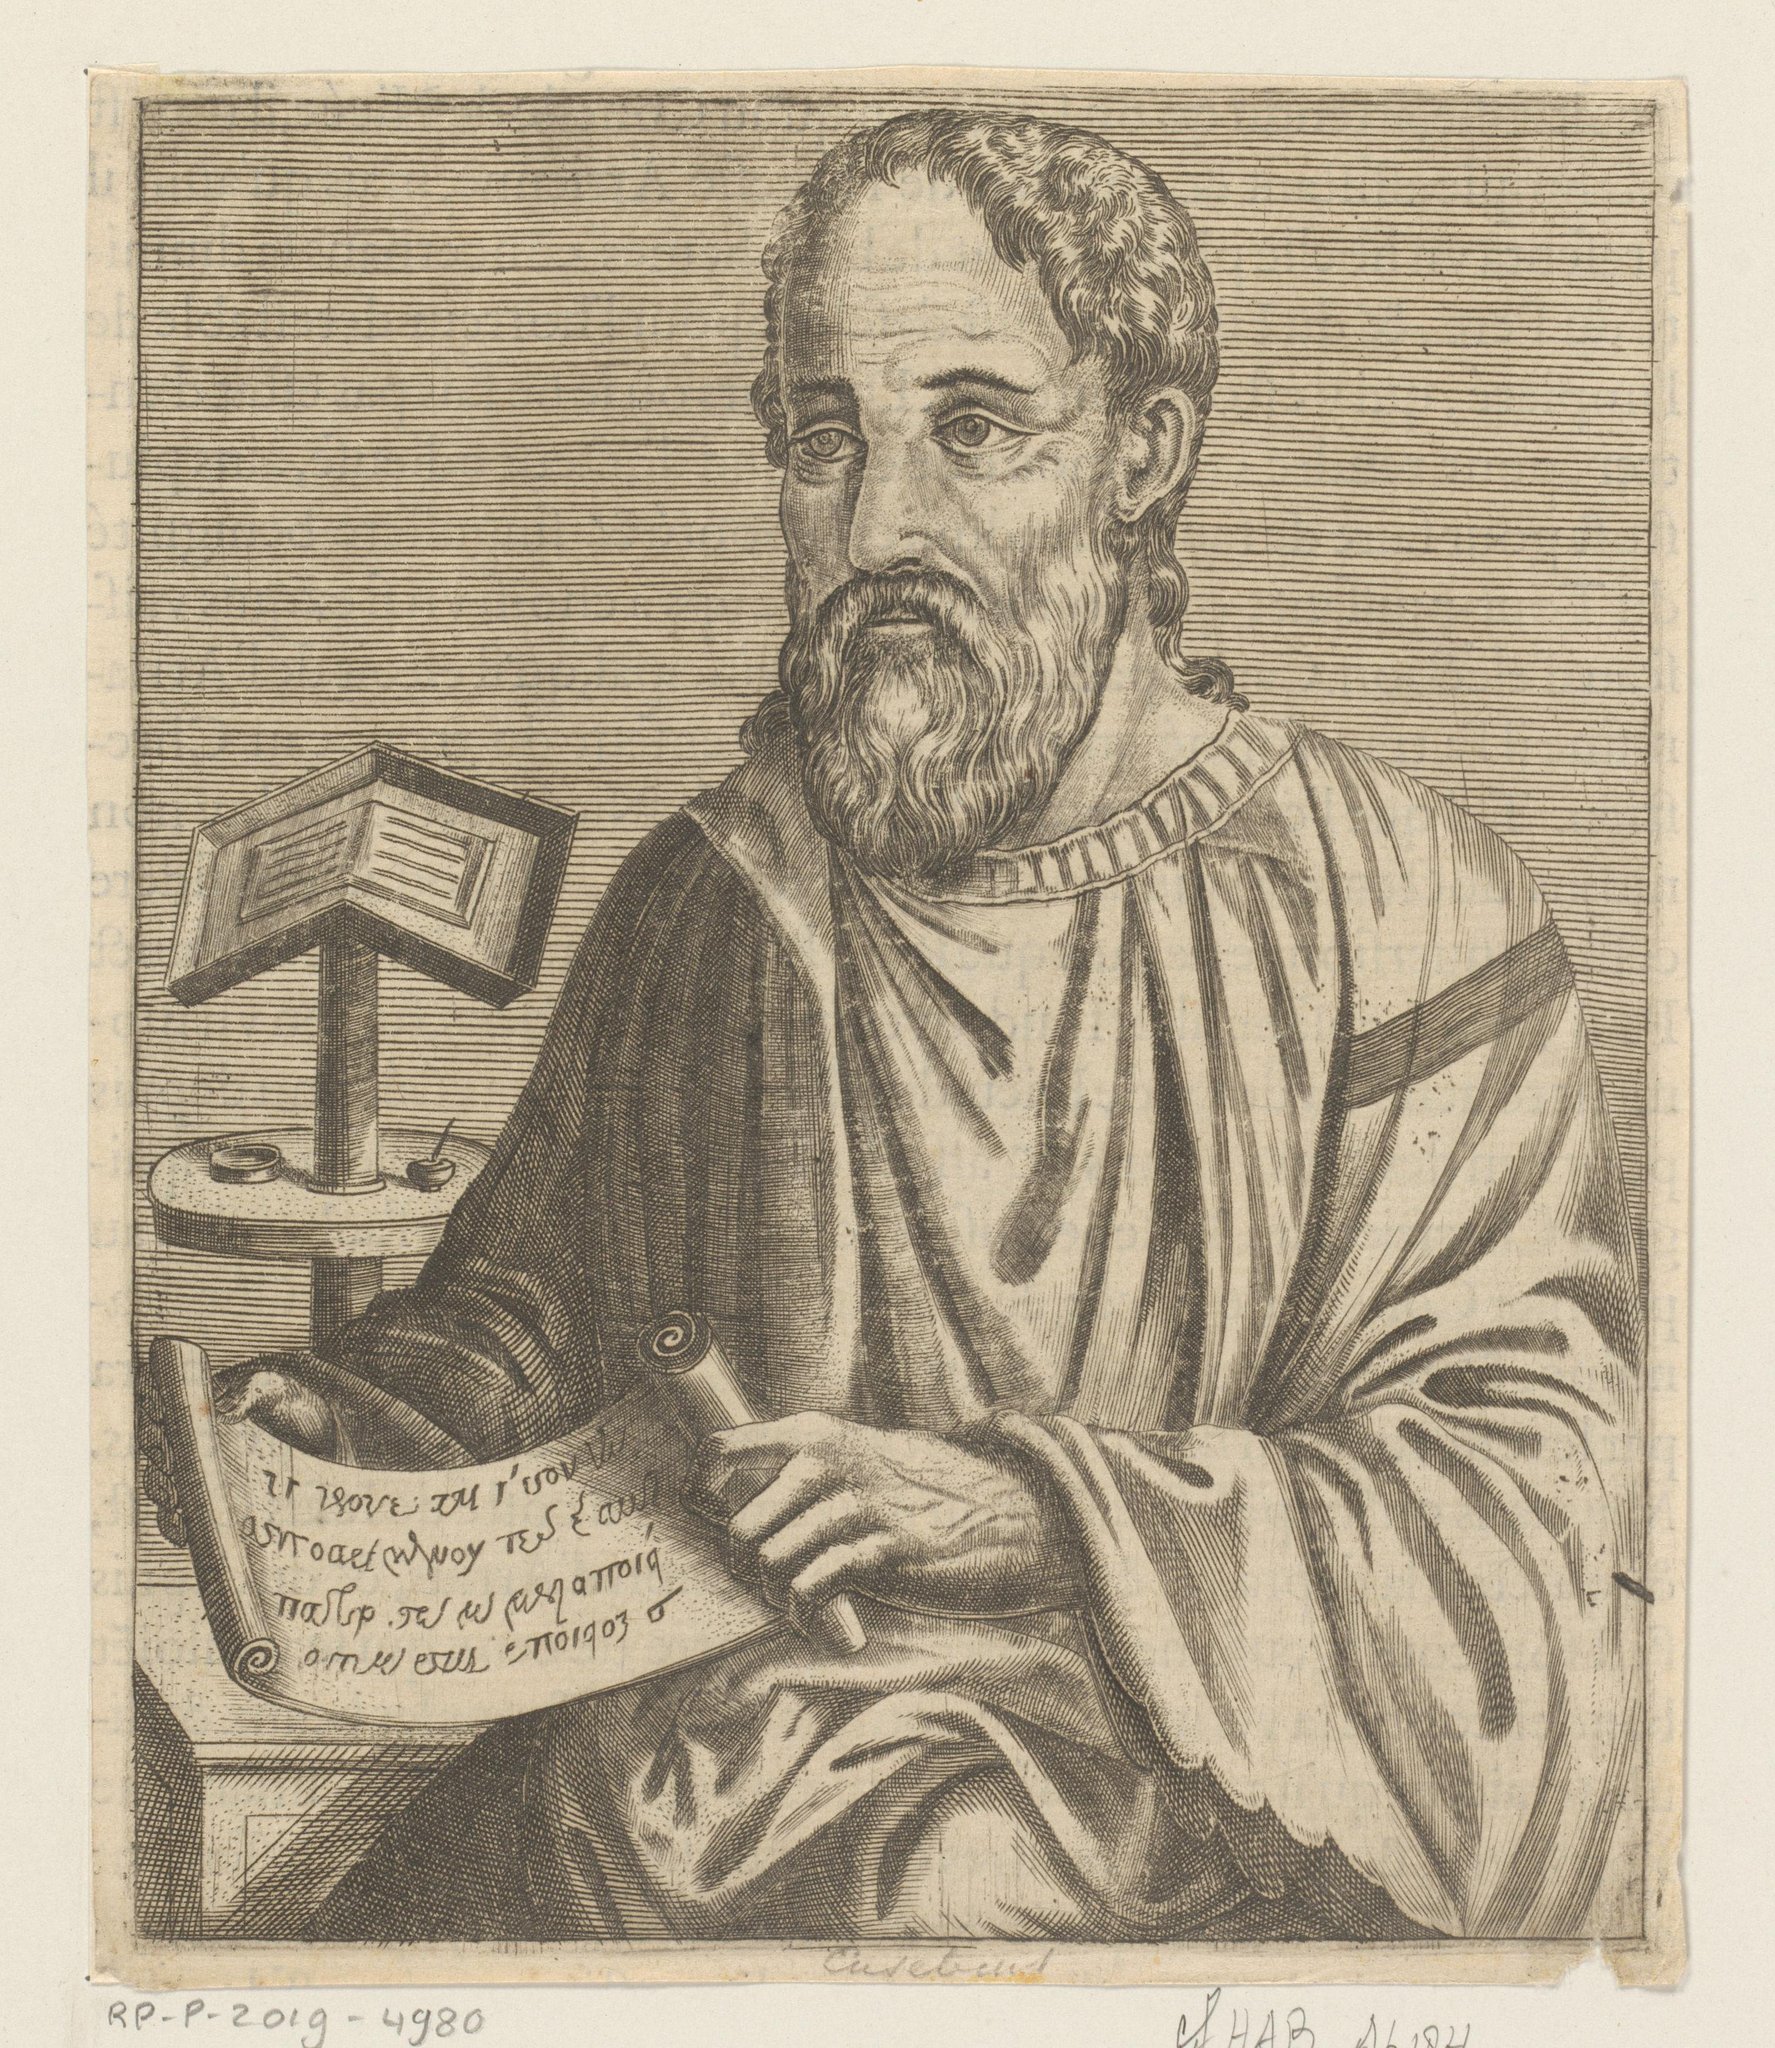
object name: print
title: Portret van Eusebius van Caesarea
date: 1584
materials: paper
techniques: engraving, letterpress printing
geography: paris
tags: historical persons, male persons from classical history (eusebius of caesarea), book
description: Prent uit: Thevet, André. Les vrais pourtraits et vies des hommes illustres grecz, latins et payens (...). Parijs: weduwe Jacques Kerver en Guillaume Chaudière, 1584, dl. 1, f. 86.